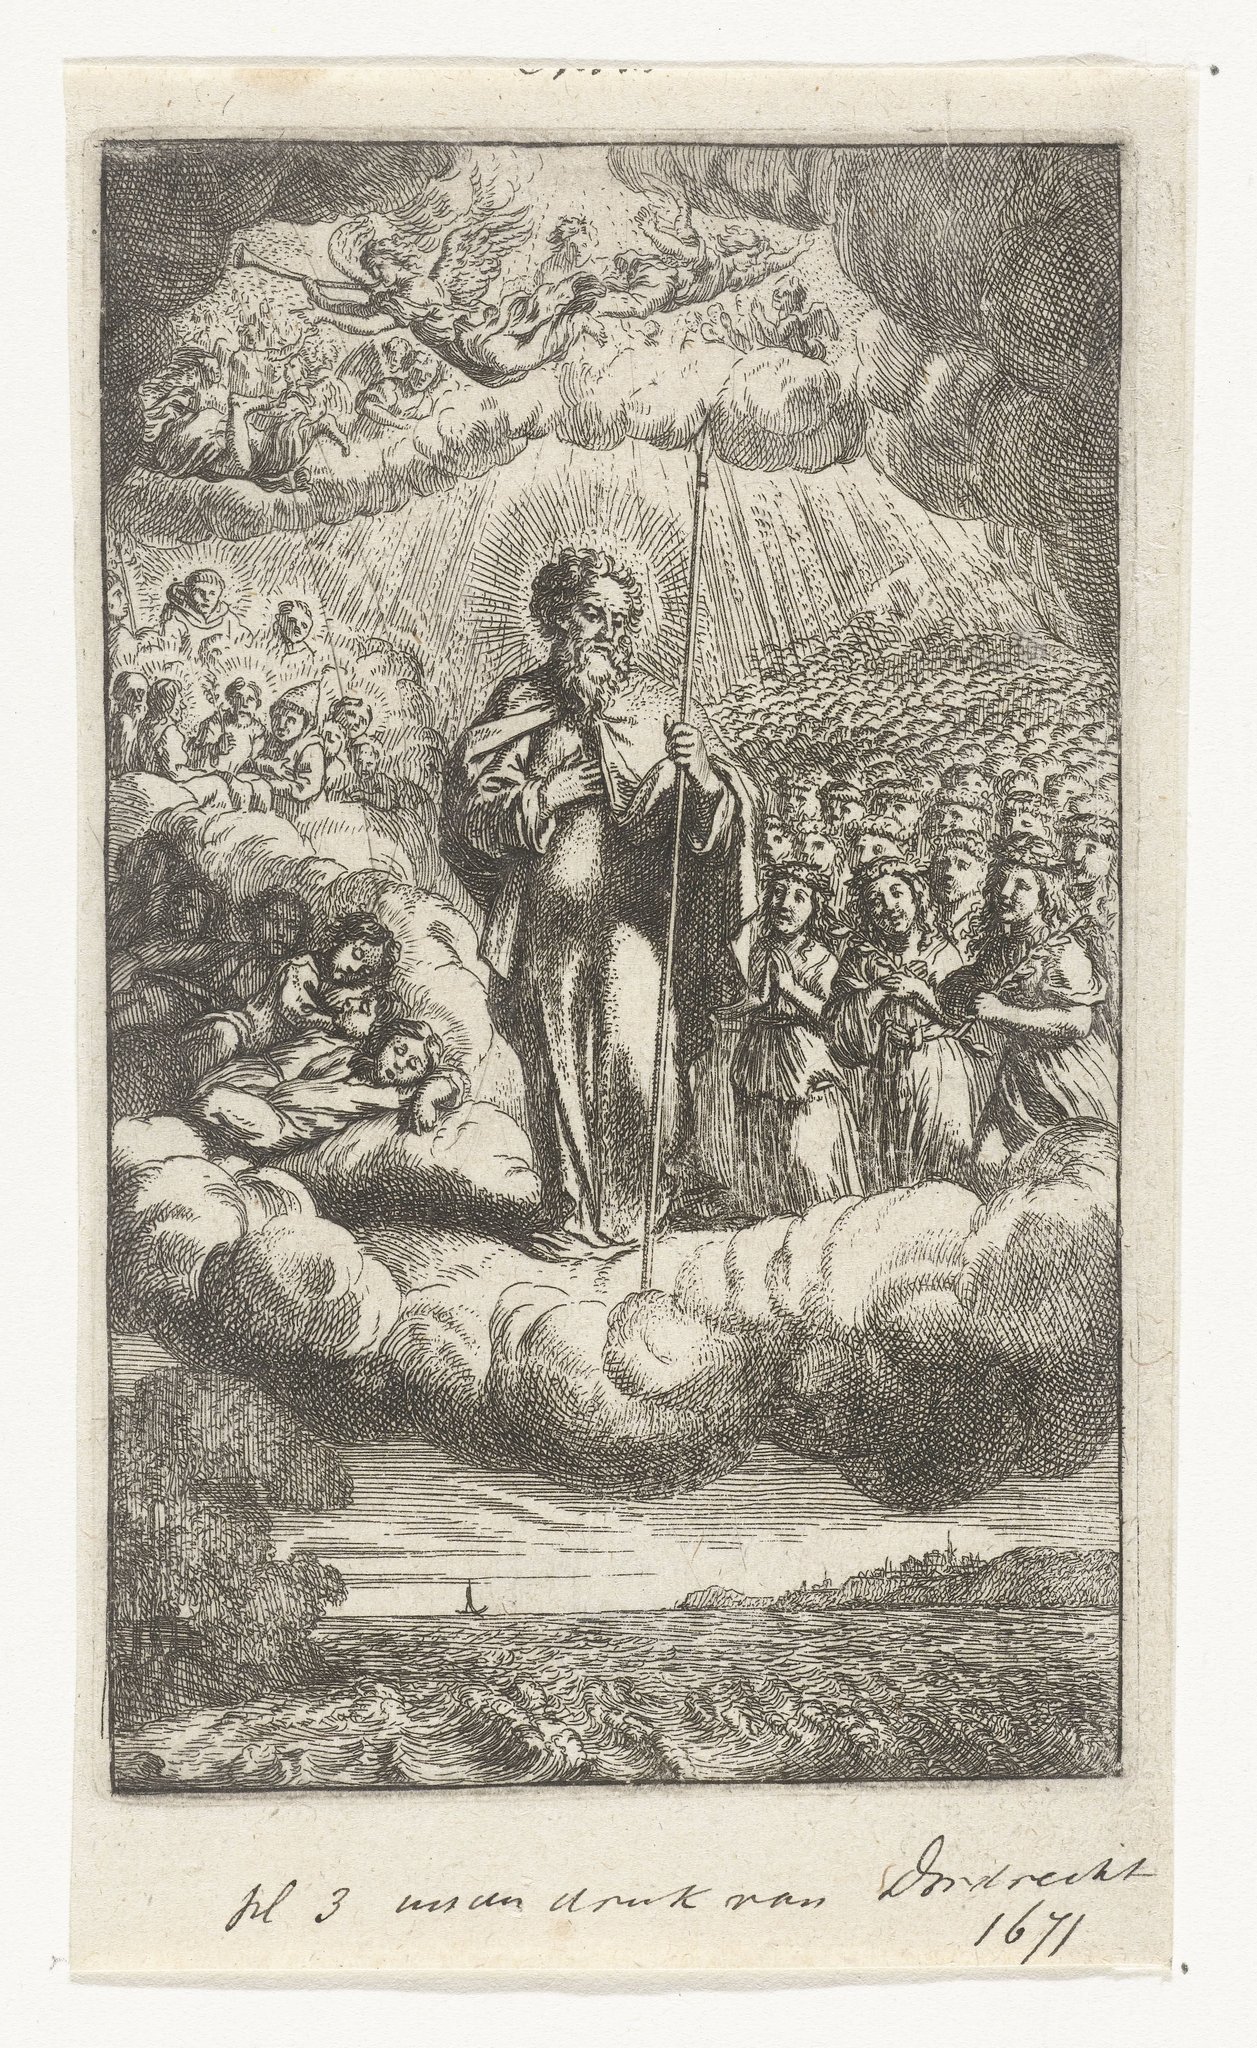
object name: book illustration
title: Heilige Thomas in de hemel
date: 1648-1671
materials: paper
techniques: etching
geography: netherlands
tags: the apostle thomas; possible attributes: book, chalice, girdle, heart, lance or spear, scroll, square, stones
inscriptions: collector's mark: Lugt 2228a, inscription: ‘pl 3 uit den druk van Dordrecht 1671’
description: De heilige Thomas op de wolken staand met een speer in de linkerhand. Rechts van hem een groot aantal martelaren met palmtakken en links zeven slapende personen